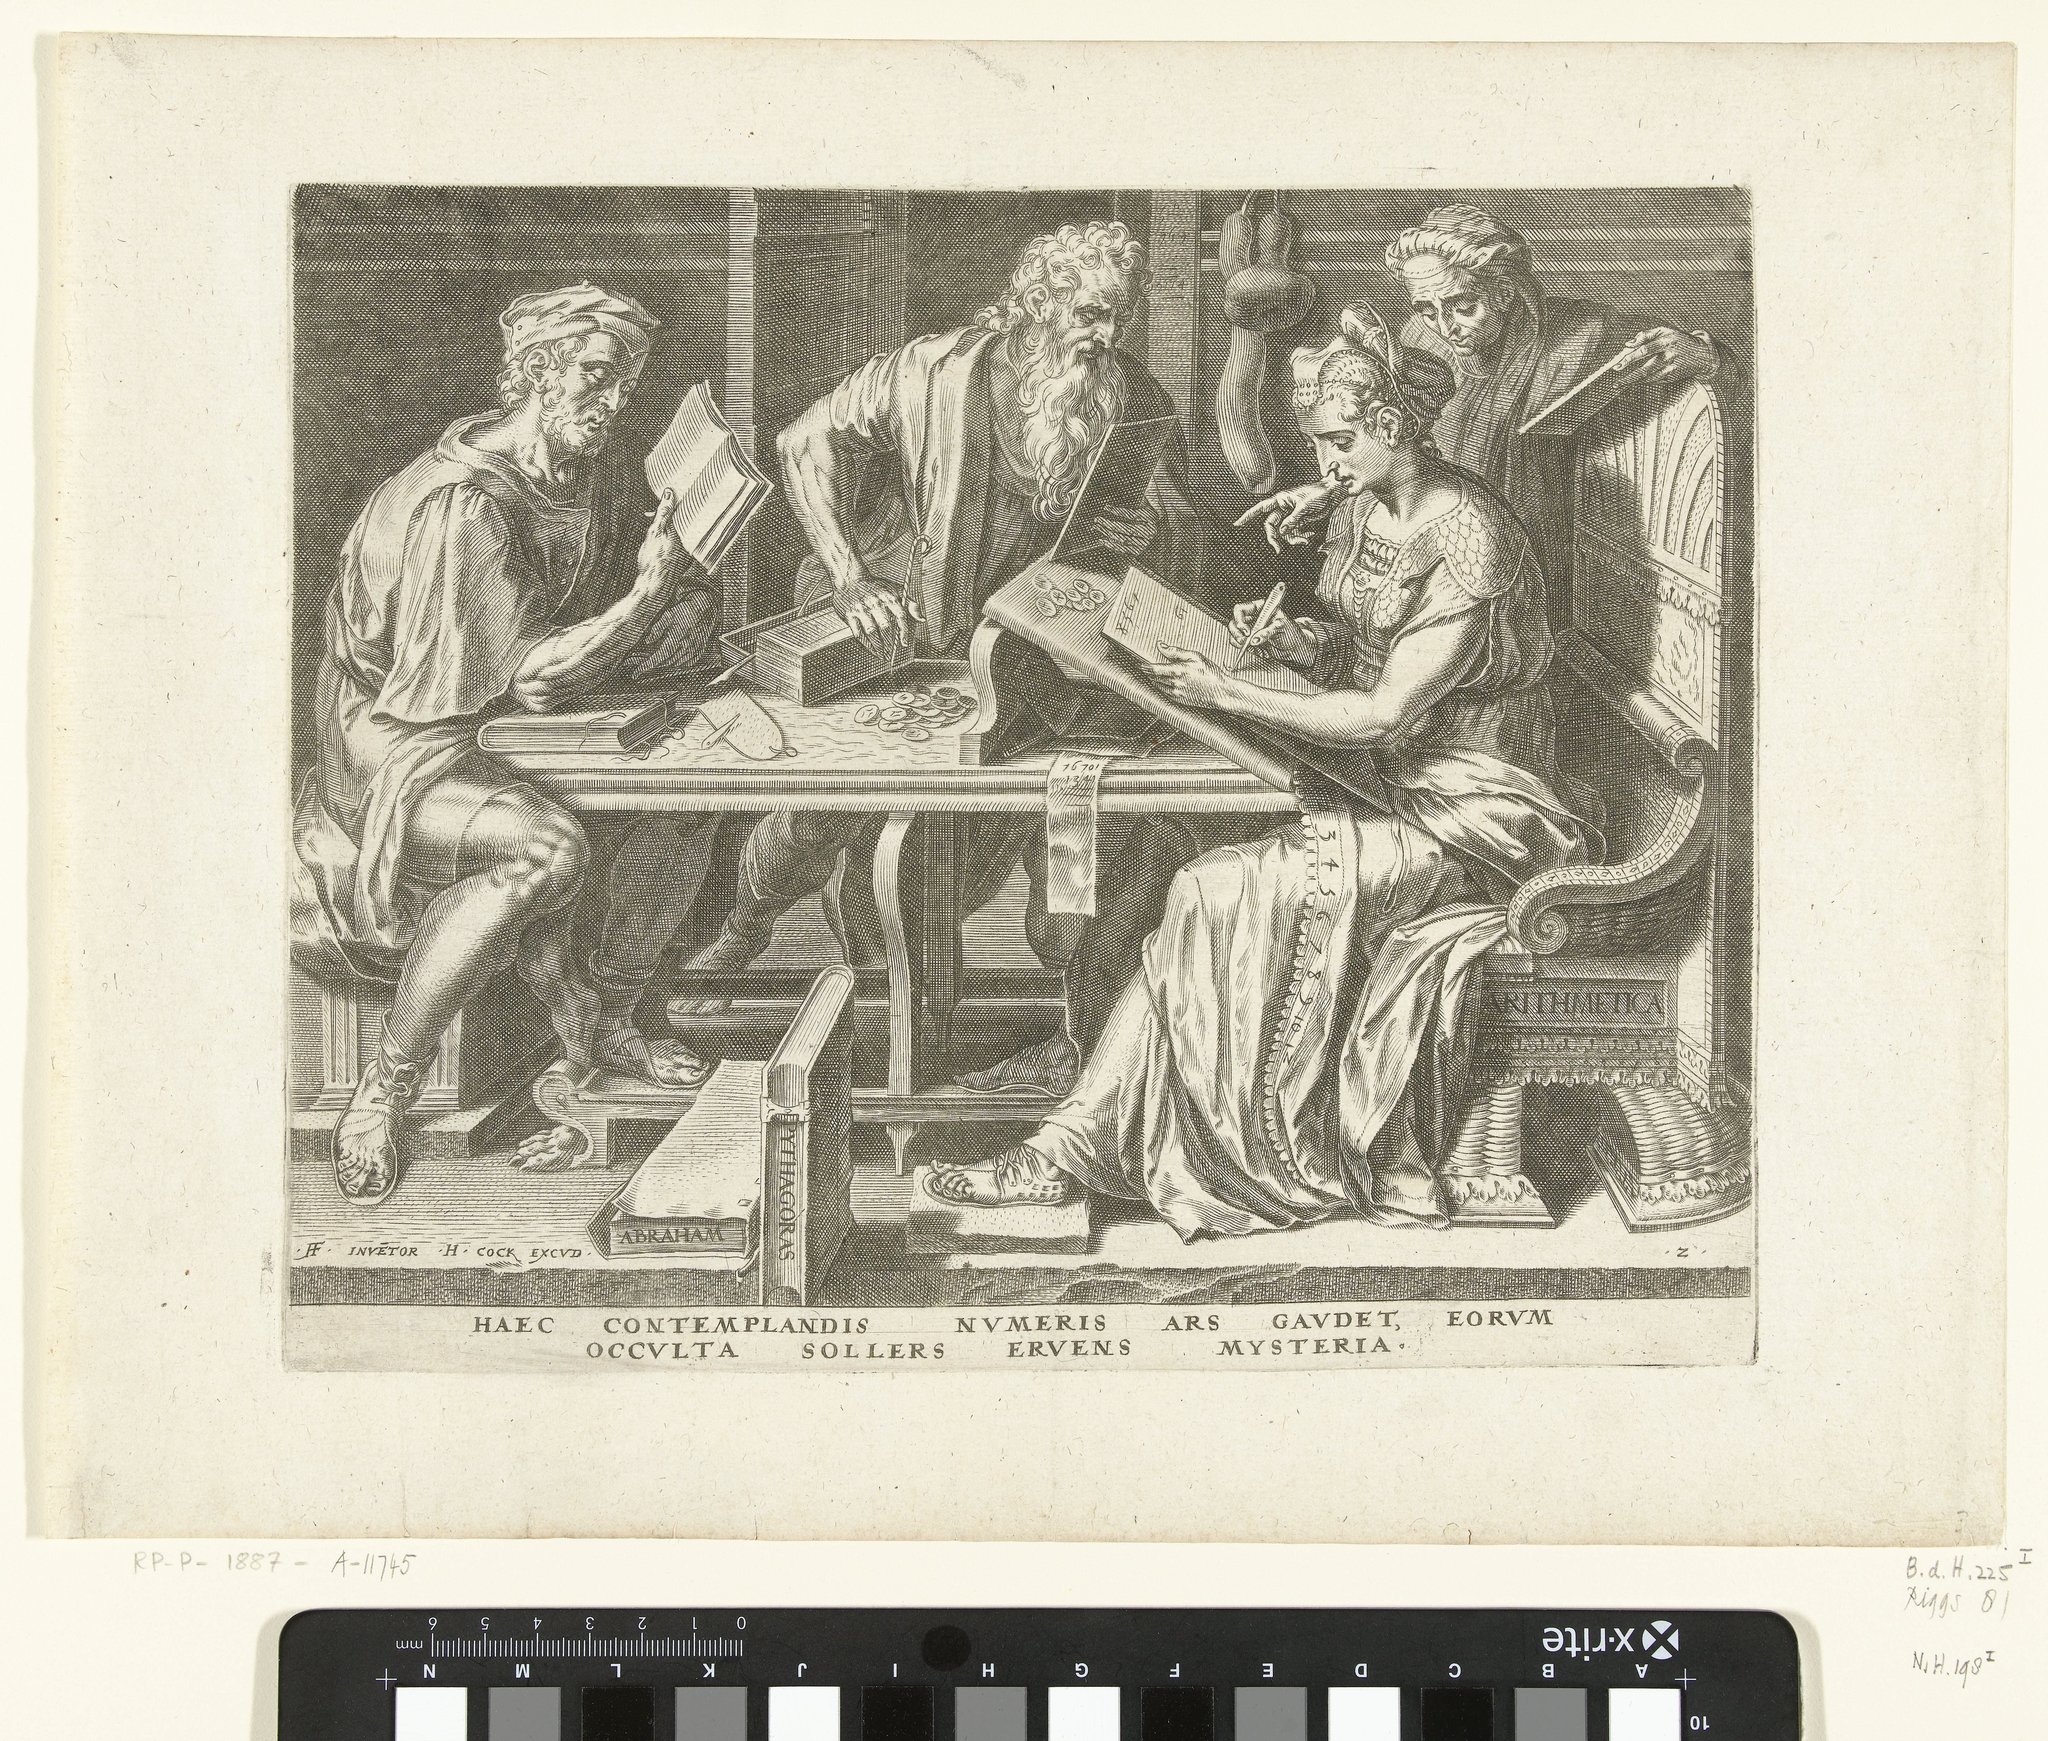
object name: print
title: De zeven vrije kunsten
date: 1565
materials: paper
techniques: engraving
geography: antwerp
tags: 'arithmetica' (~ quadrivium); 'aritmetica' (ripa)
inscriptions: caption:, collector's mark: Lugt 2228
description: Arithmetica zit aan tafel in een kantoor en schrijft een rekening. Drie medewerkers van haar tellen geld, controleren de boeken en schrijven eveneens rekeningen uit. De zoom van Arithmetica's jurk is versiert met getallen.